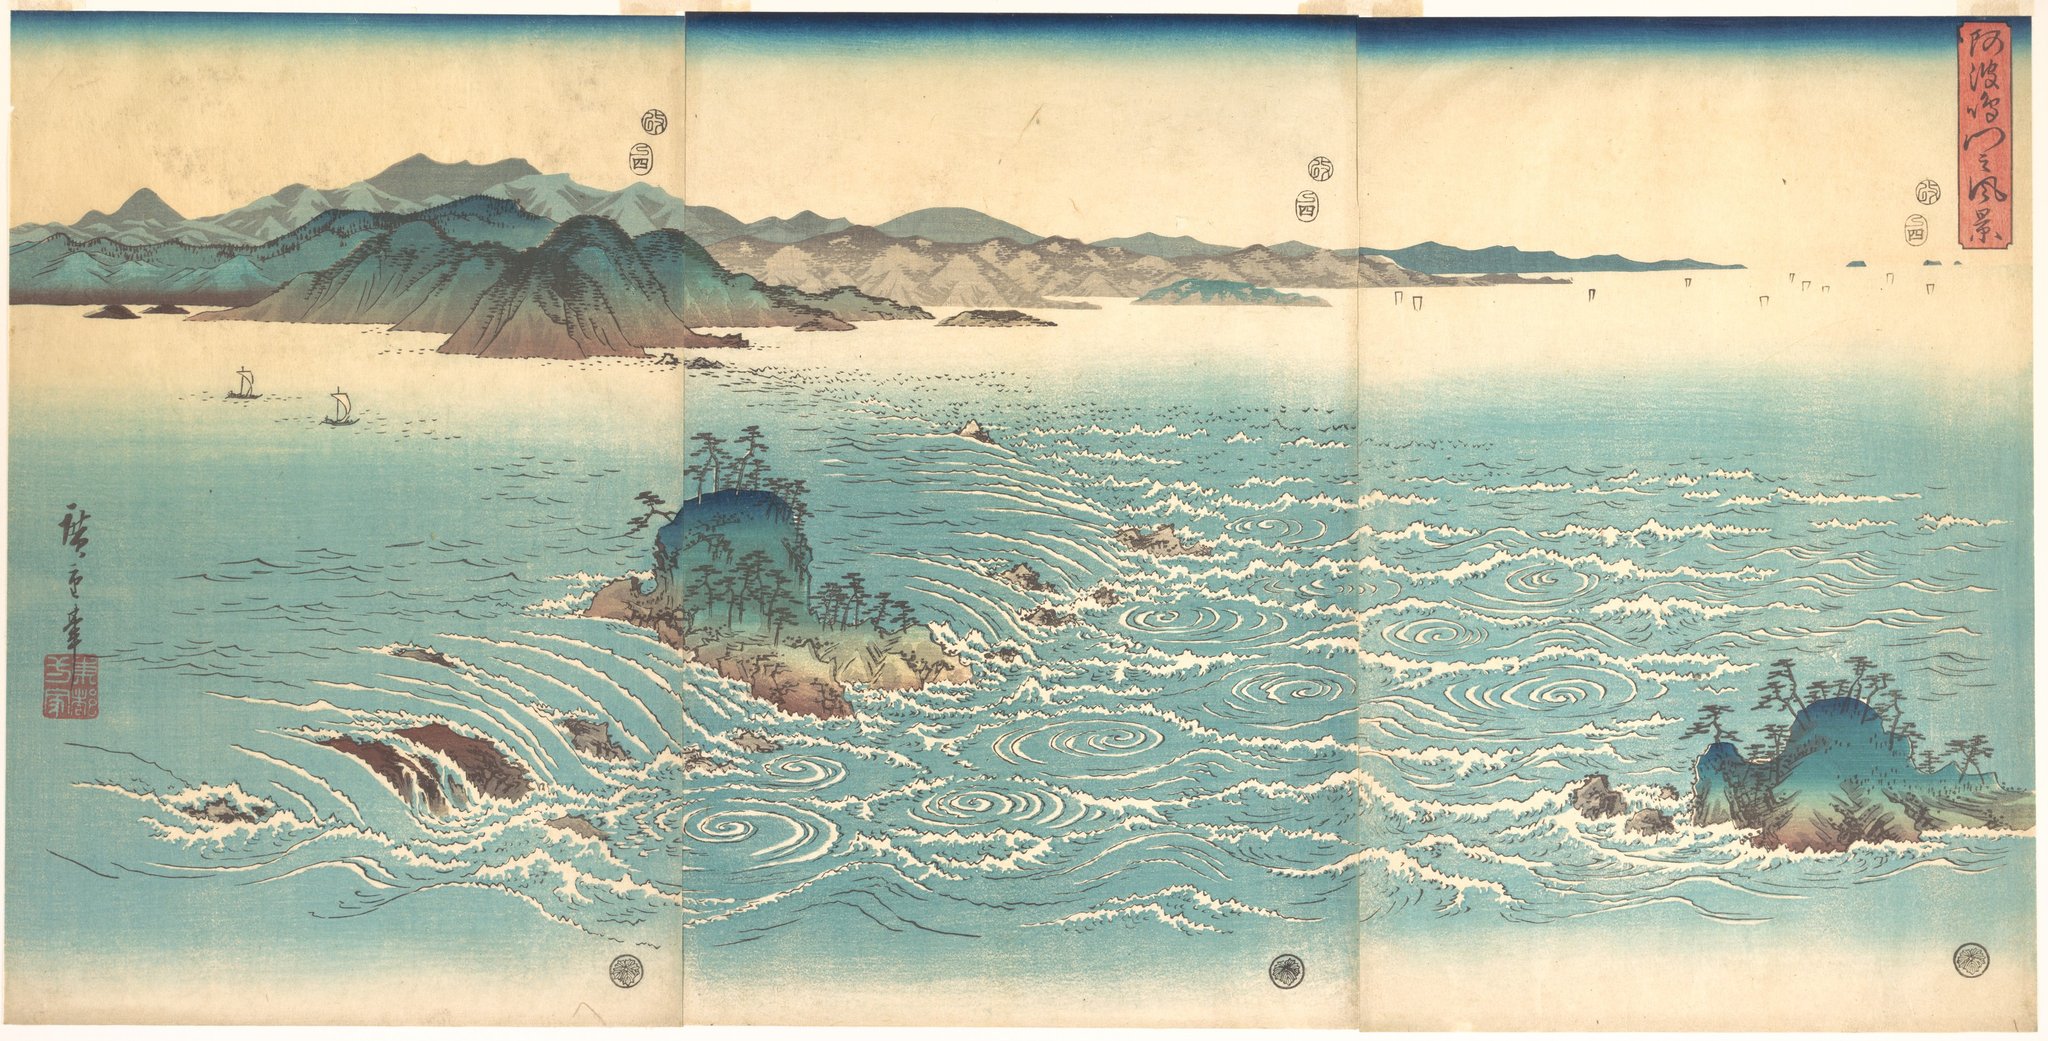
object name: print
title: Rapids at Naruto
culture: japanese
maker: utagawa hiroshige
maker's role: artist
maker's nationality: japanese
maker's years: 1797-1858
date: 1857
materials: ink, paper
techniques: woodblock print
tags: mountains,seascapes